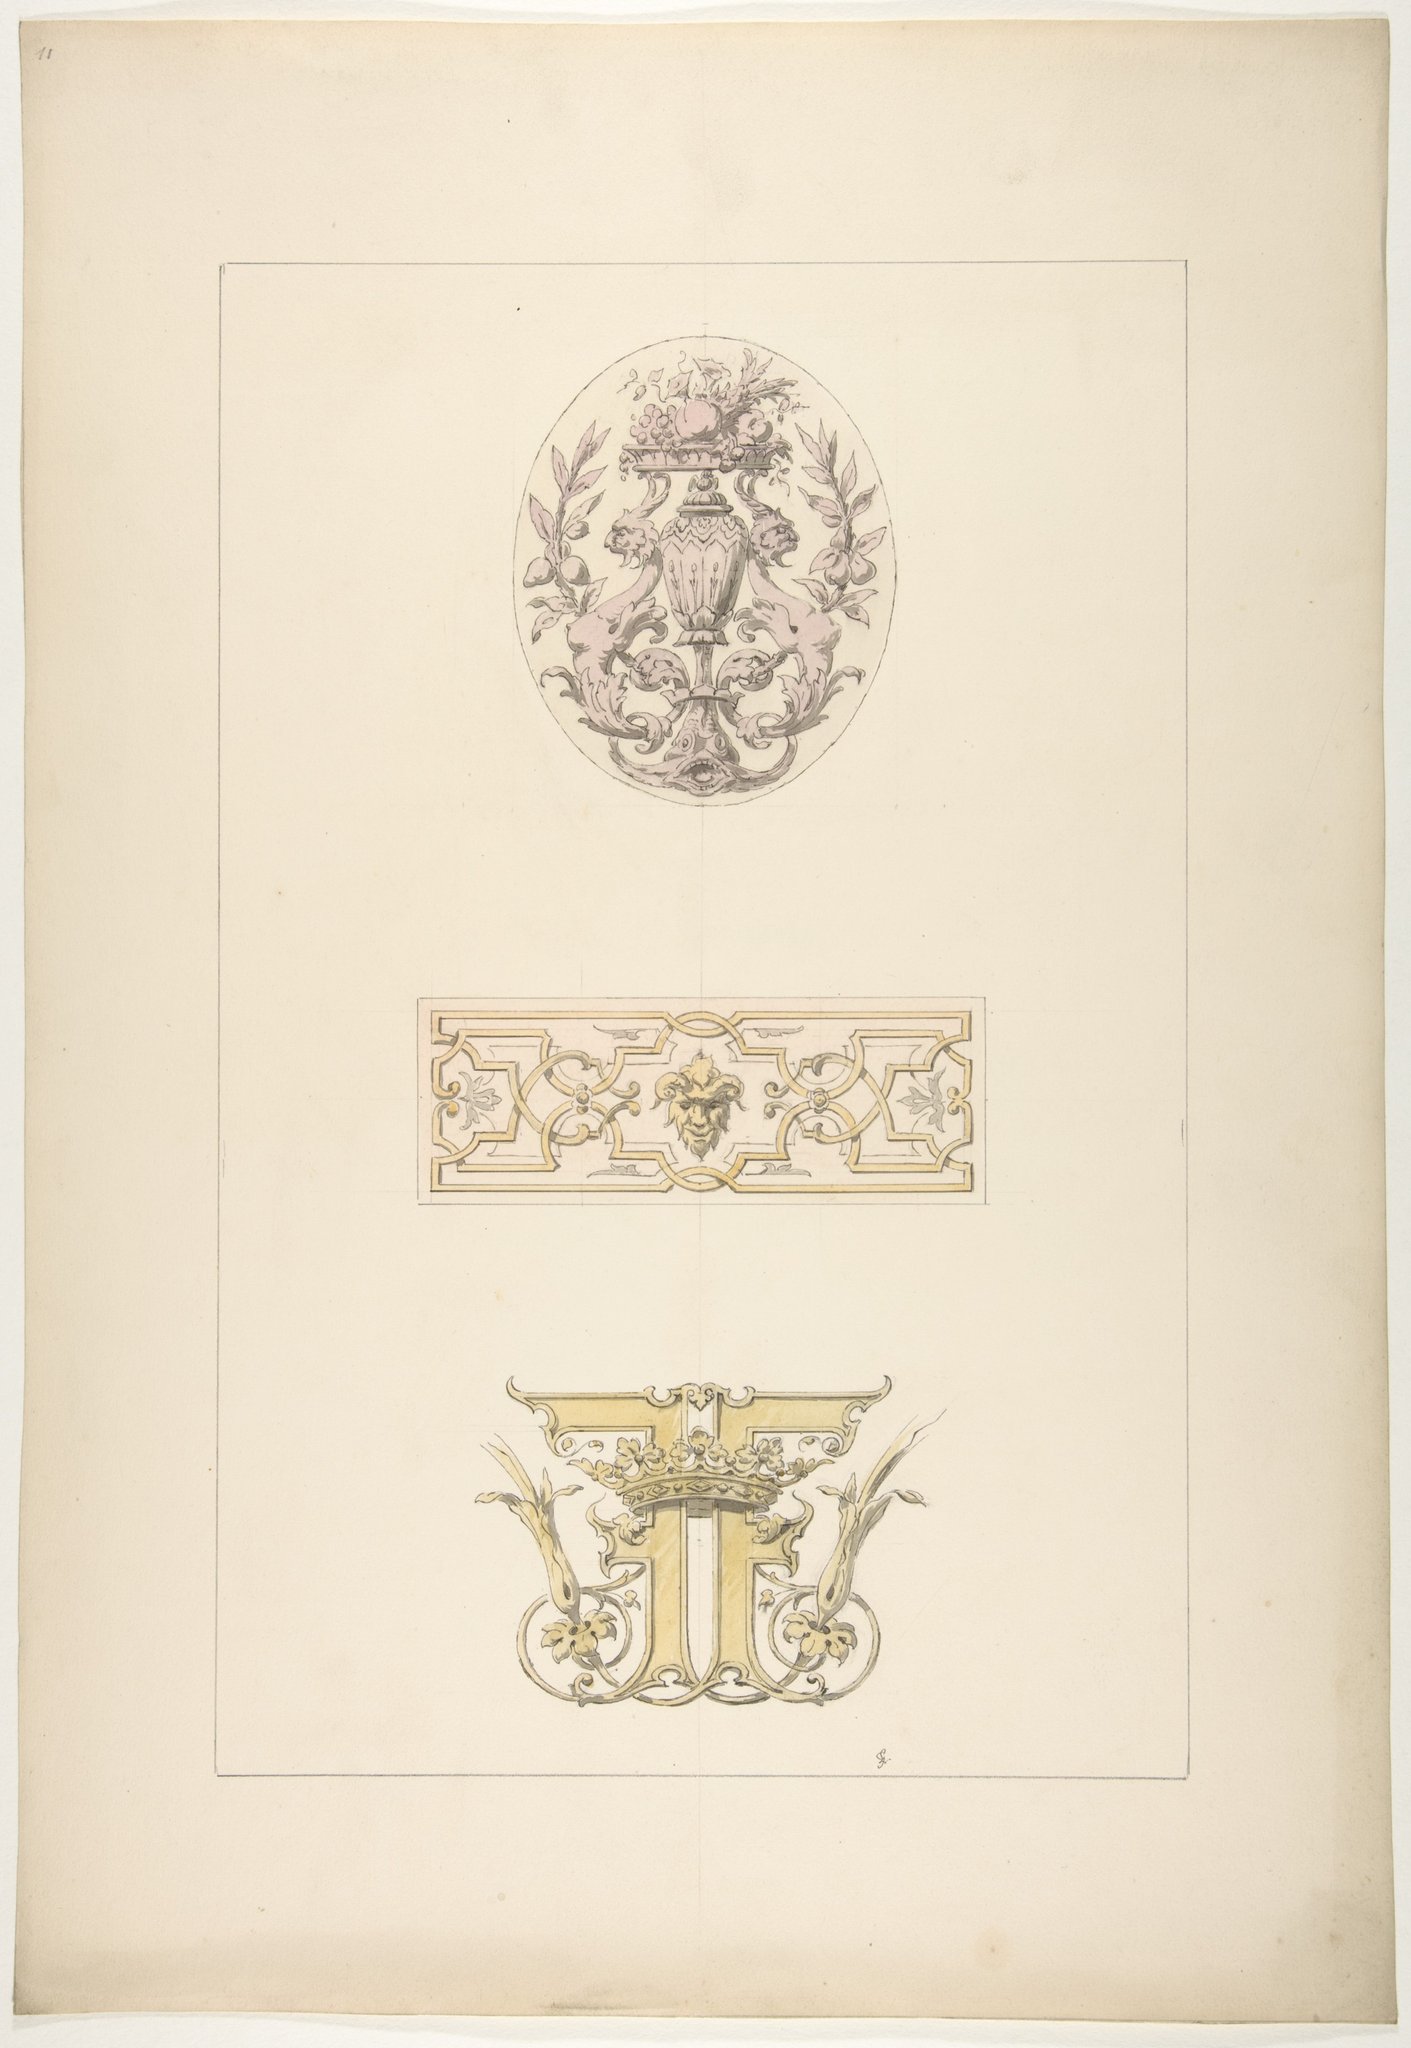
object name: drawing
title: Two designs for decorative panels and one design for an ornamental monogram with a crown and the initials: FF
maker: jules-edmond-charles lachaise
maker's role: artist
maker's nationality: french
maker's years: 1897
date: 1830-1897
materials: graphite, watercolor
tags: ornament,insignia